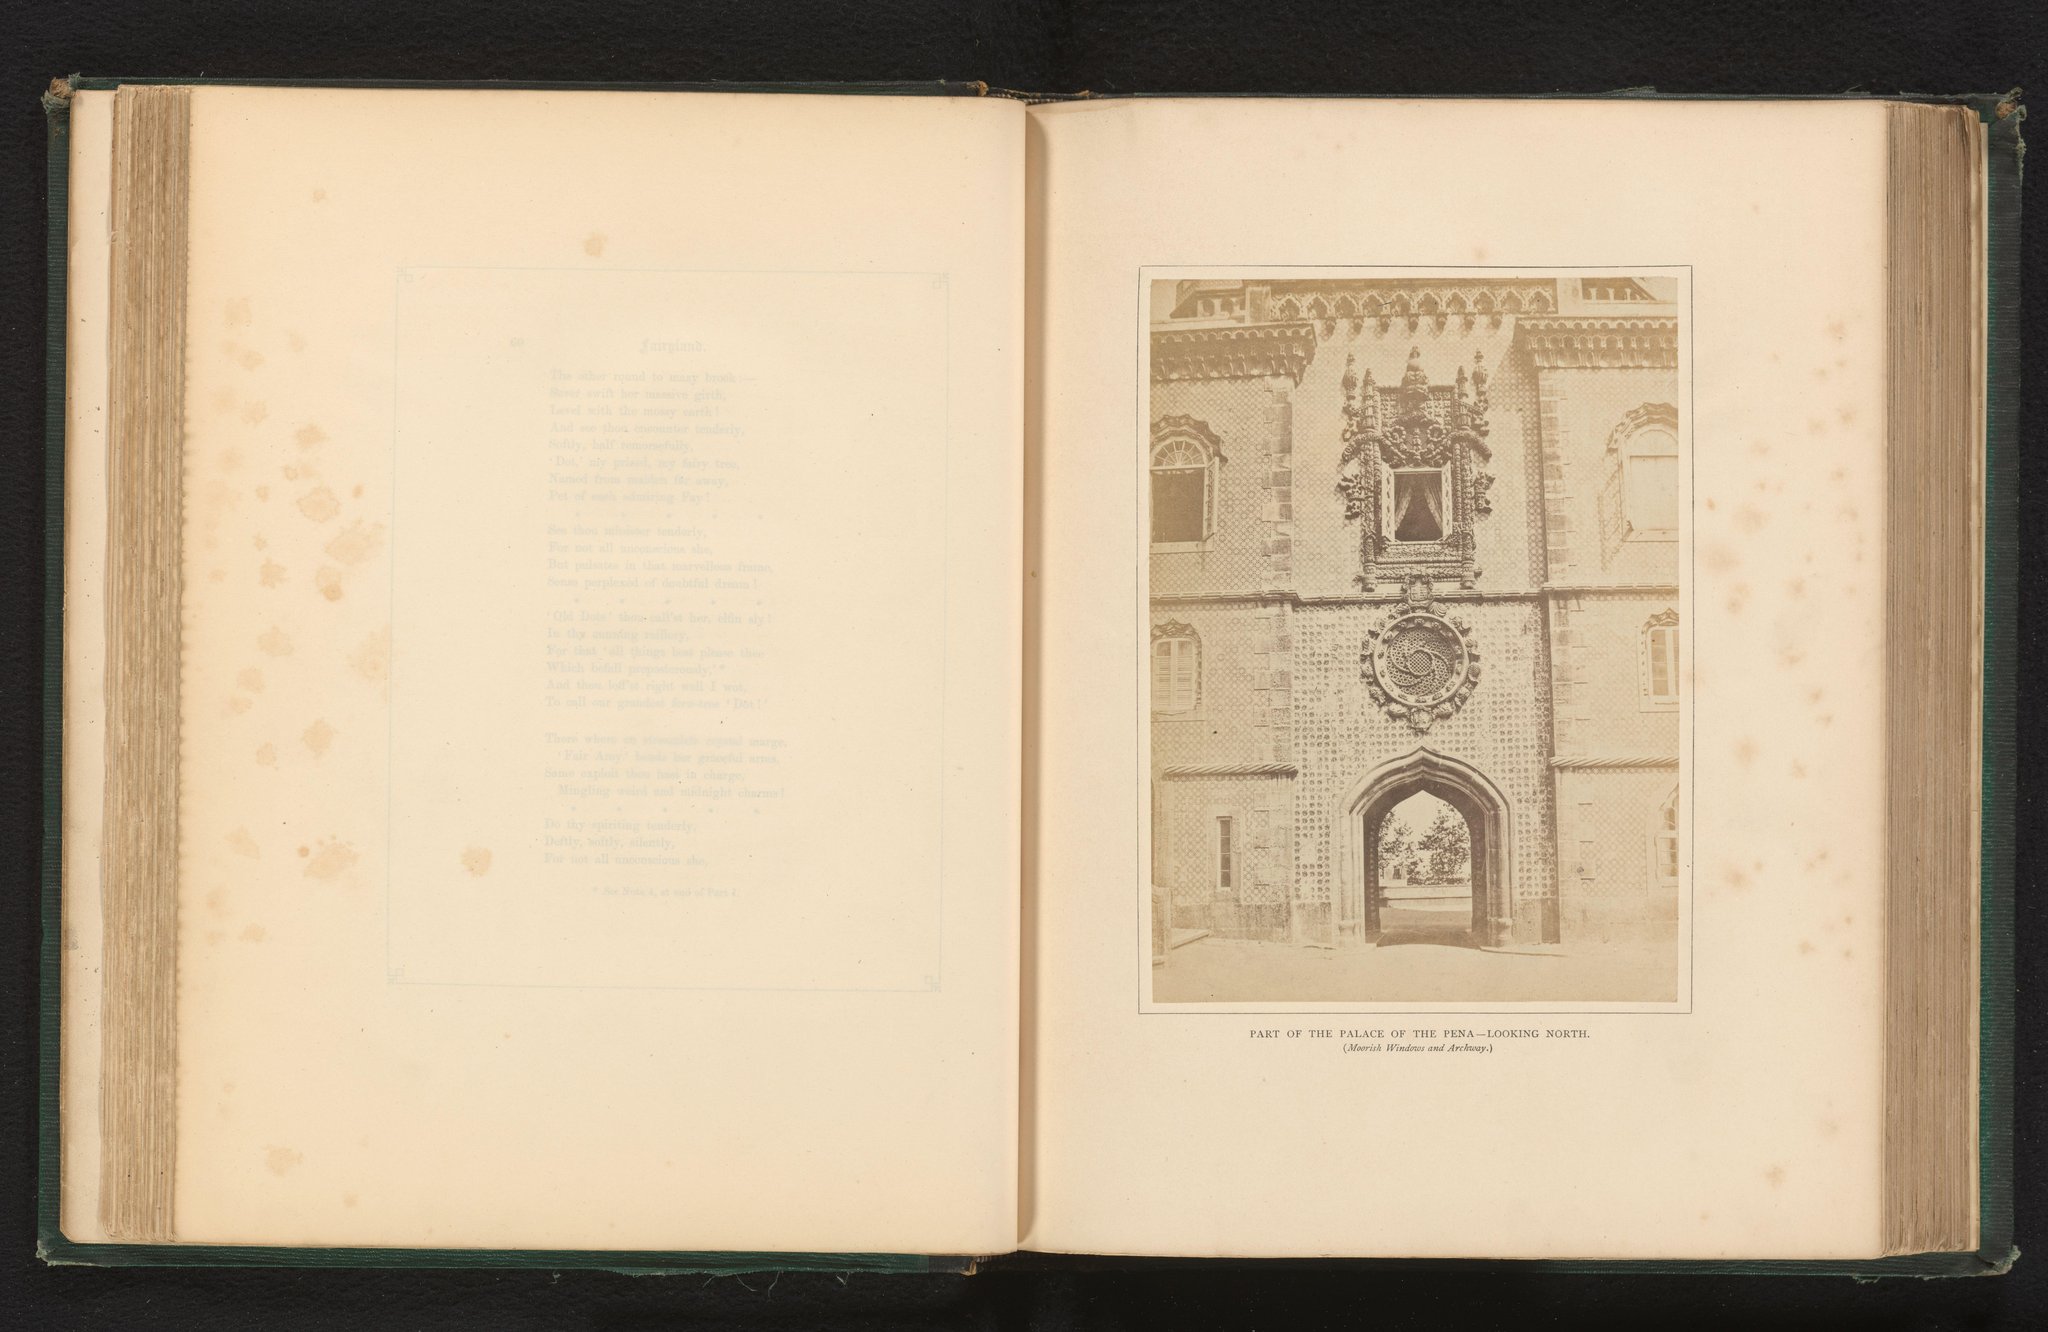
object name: photograph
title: Part of the Palace of the Pena - looking north (Moorish Windows and Archway)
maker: Anonymous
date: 1865-1870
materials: paper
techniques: albumen print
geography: sintra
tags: palace, gate, entrance